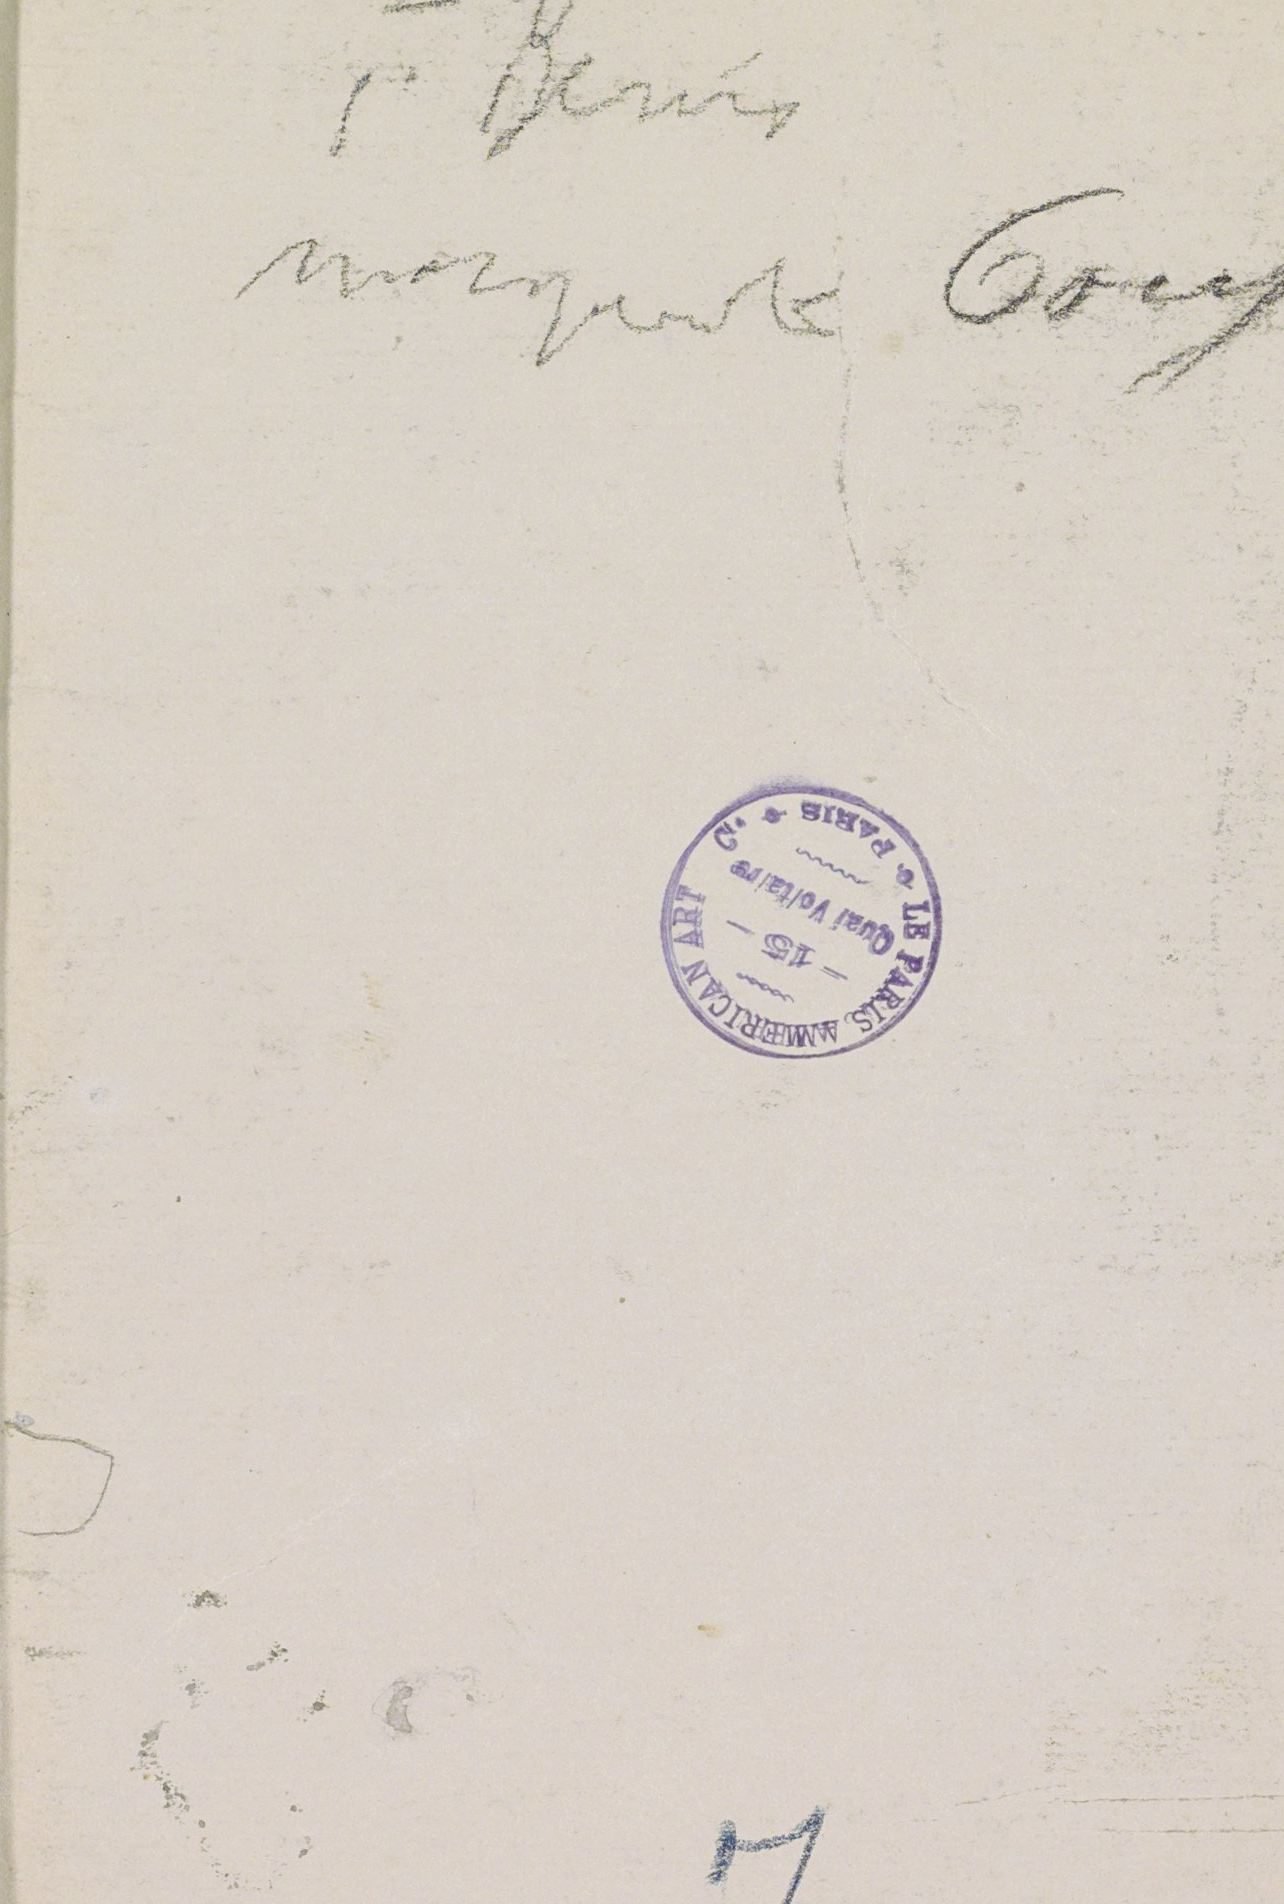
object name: sketchbook leaf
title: Annotaties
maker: isaac israels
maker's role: draughtsman, painter, print maker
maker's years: 1865-1934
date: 1875-1934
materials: chalk, paper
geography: paris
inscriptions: annotation: ‘[...]’, retailer's mark: ‘Le Paris American Art / Paris / 15 / Quai Voltaire’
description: Schutblad B, achterste schutblad, uit schetsboek L met 42 bladen.